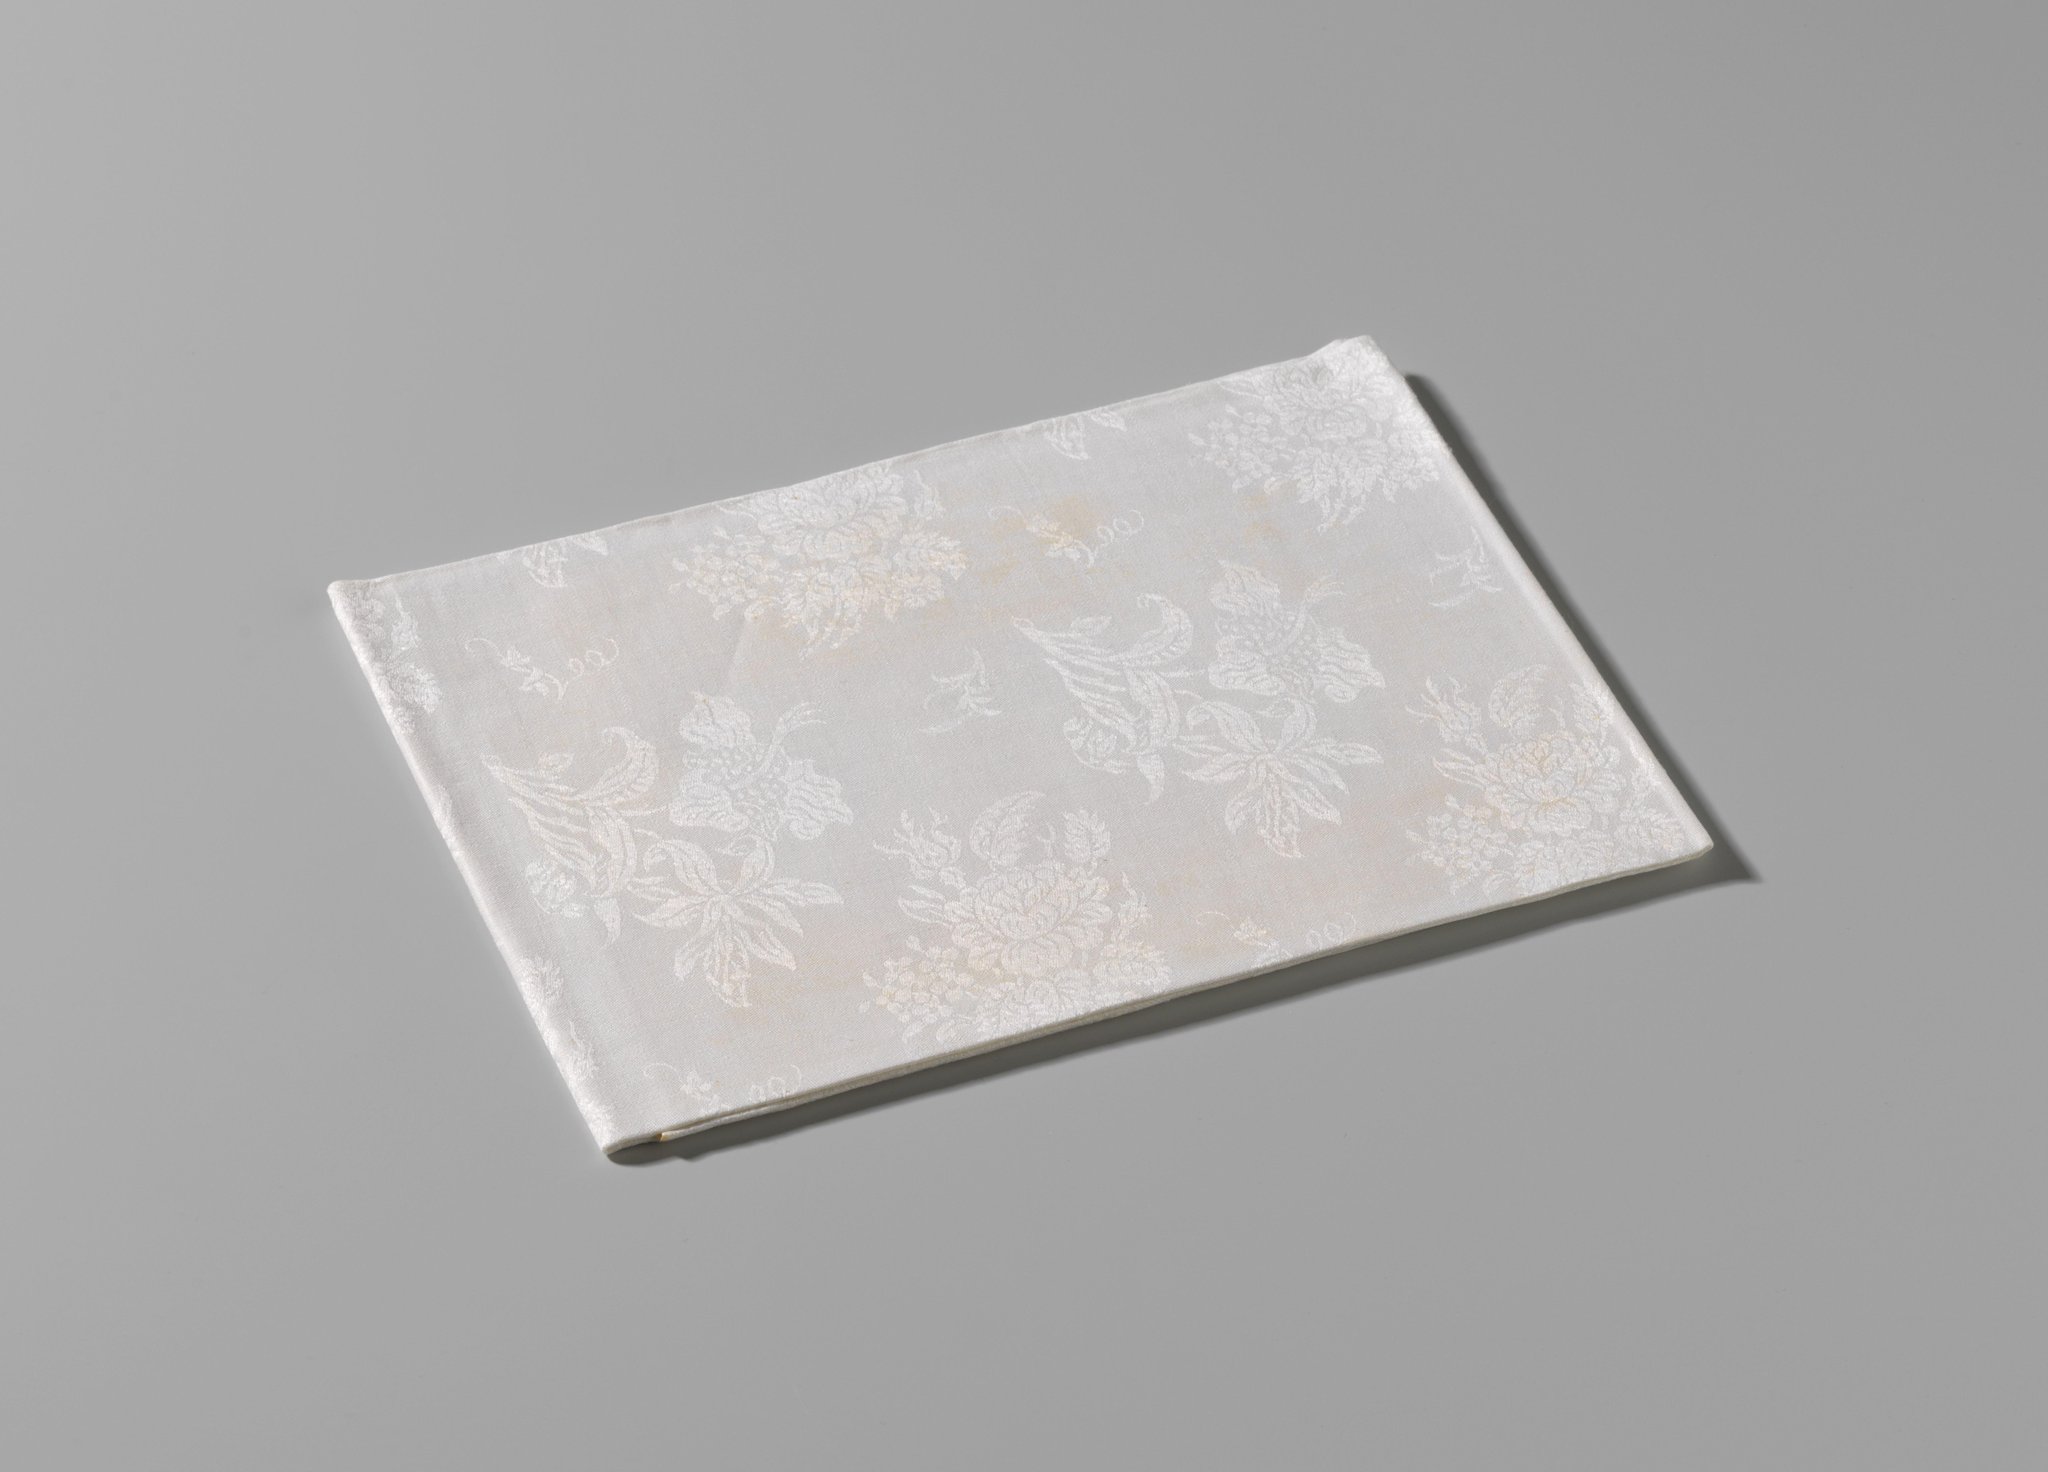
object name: napkin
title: Servet met bloemboeketten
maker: Anonymous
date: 1700-1899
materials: linen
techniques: damask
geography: saxony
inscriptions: mark: ‘GvO’, mark: ‘24’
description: Servet van linnendamast met bloemboeketten. Middenveld: Bloempatroon van verspringende rijen met twee soorten bloemboeketten. Staande en liggende randen: een bloemslinger, de hoeken een bloemboeket.